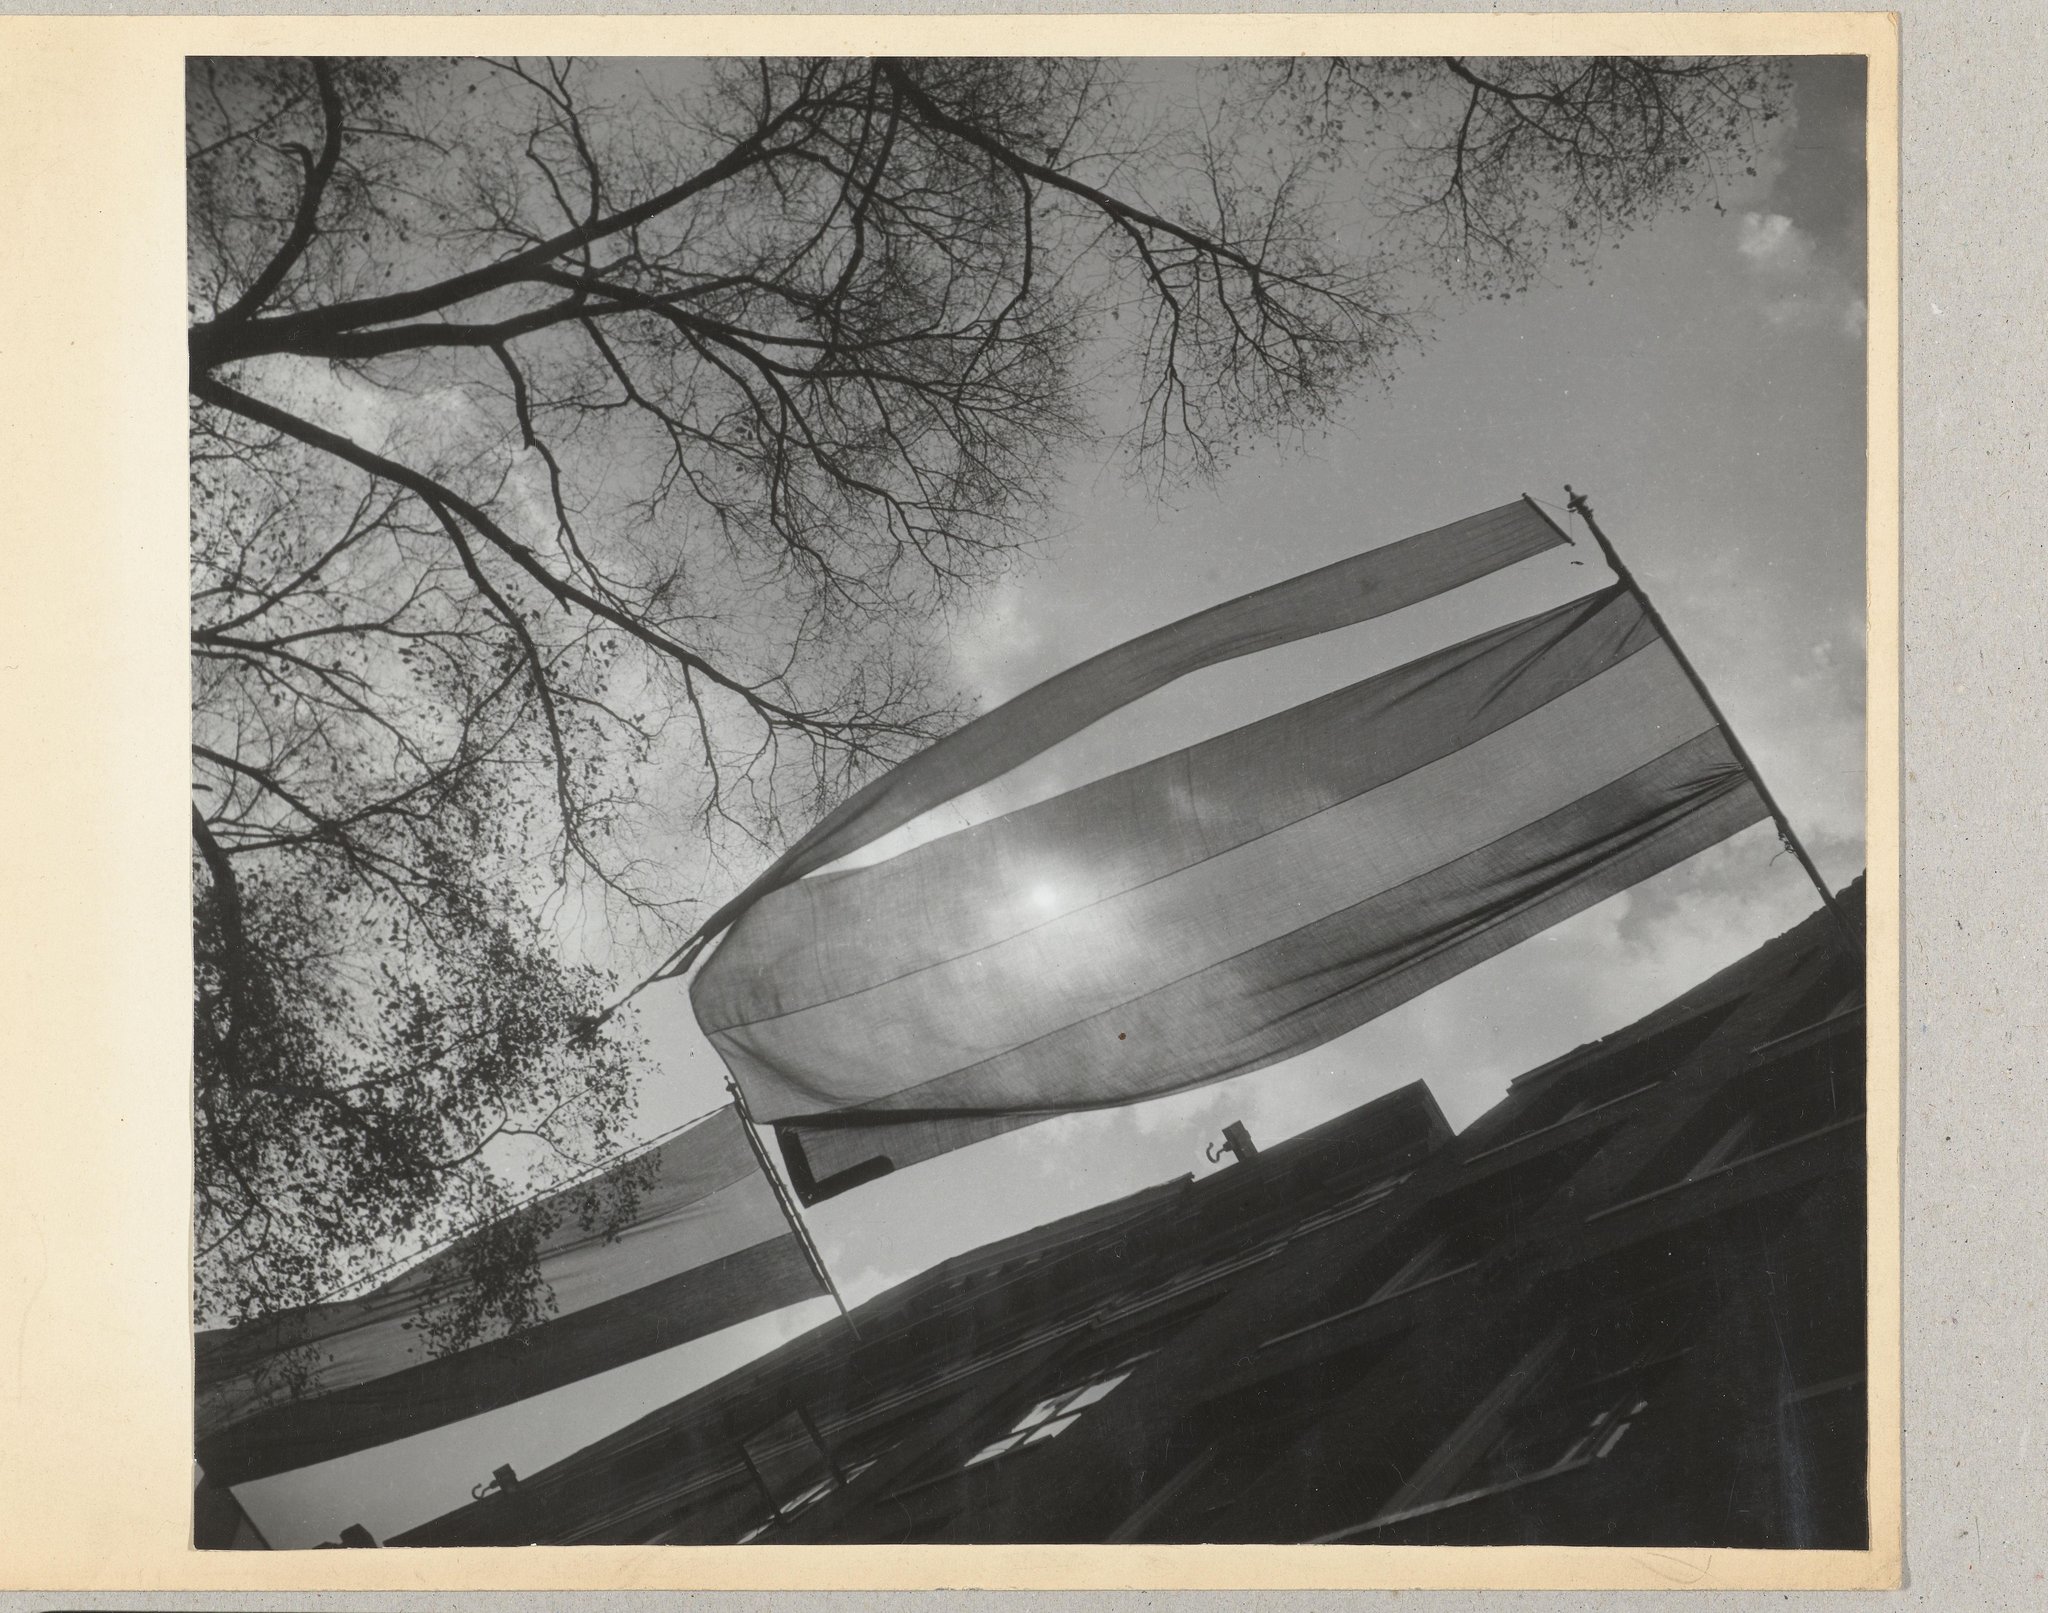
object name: photograph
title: Vlaggen hangen uit tijdens de bevrijding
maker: emmy eugenie andriesse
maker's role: fotograaf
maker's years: 1914-1953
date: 1945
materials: paper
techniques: gelatin silver print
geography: amsterdam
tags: flags flown from a mast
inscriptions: annotation: ‘bevrijding, Emmy Andriesse, Amsterdam-c o.z. achterburgwal 192’